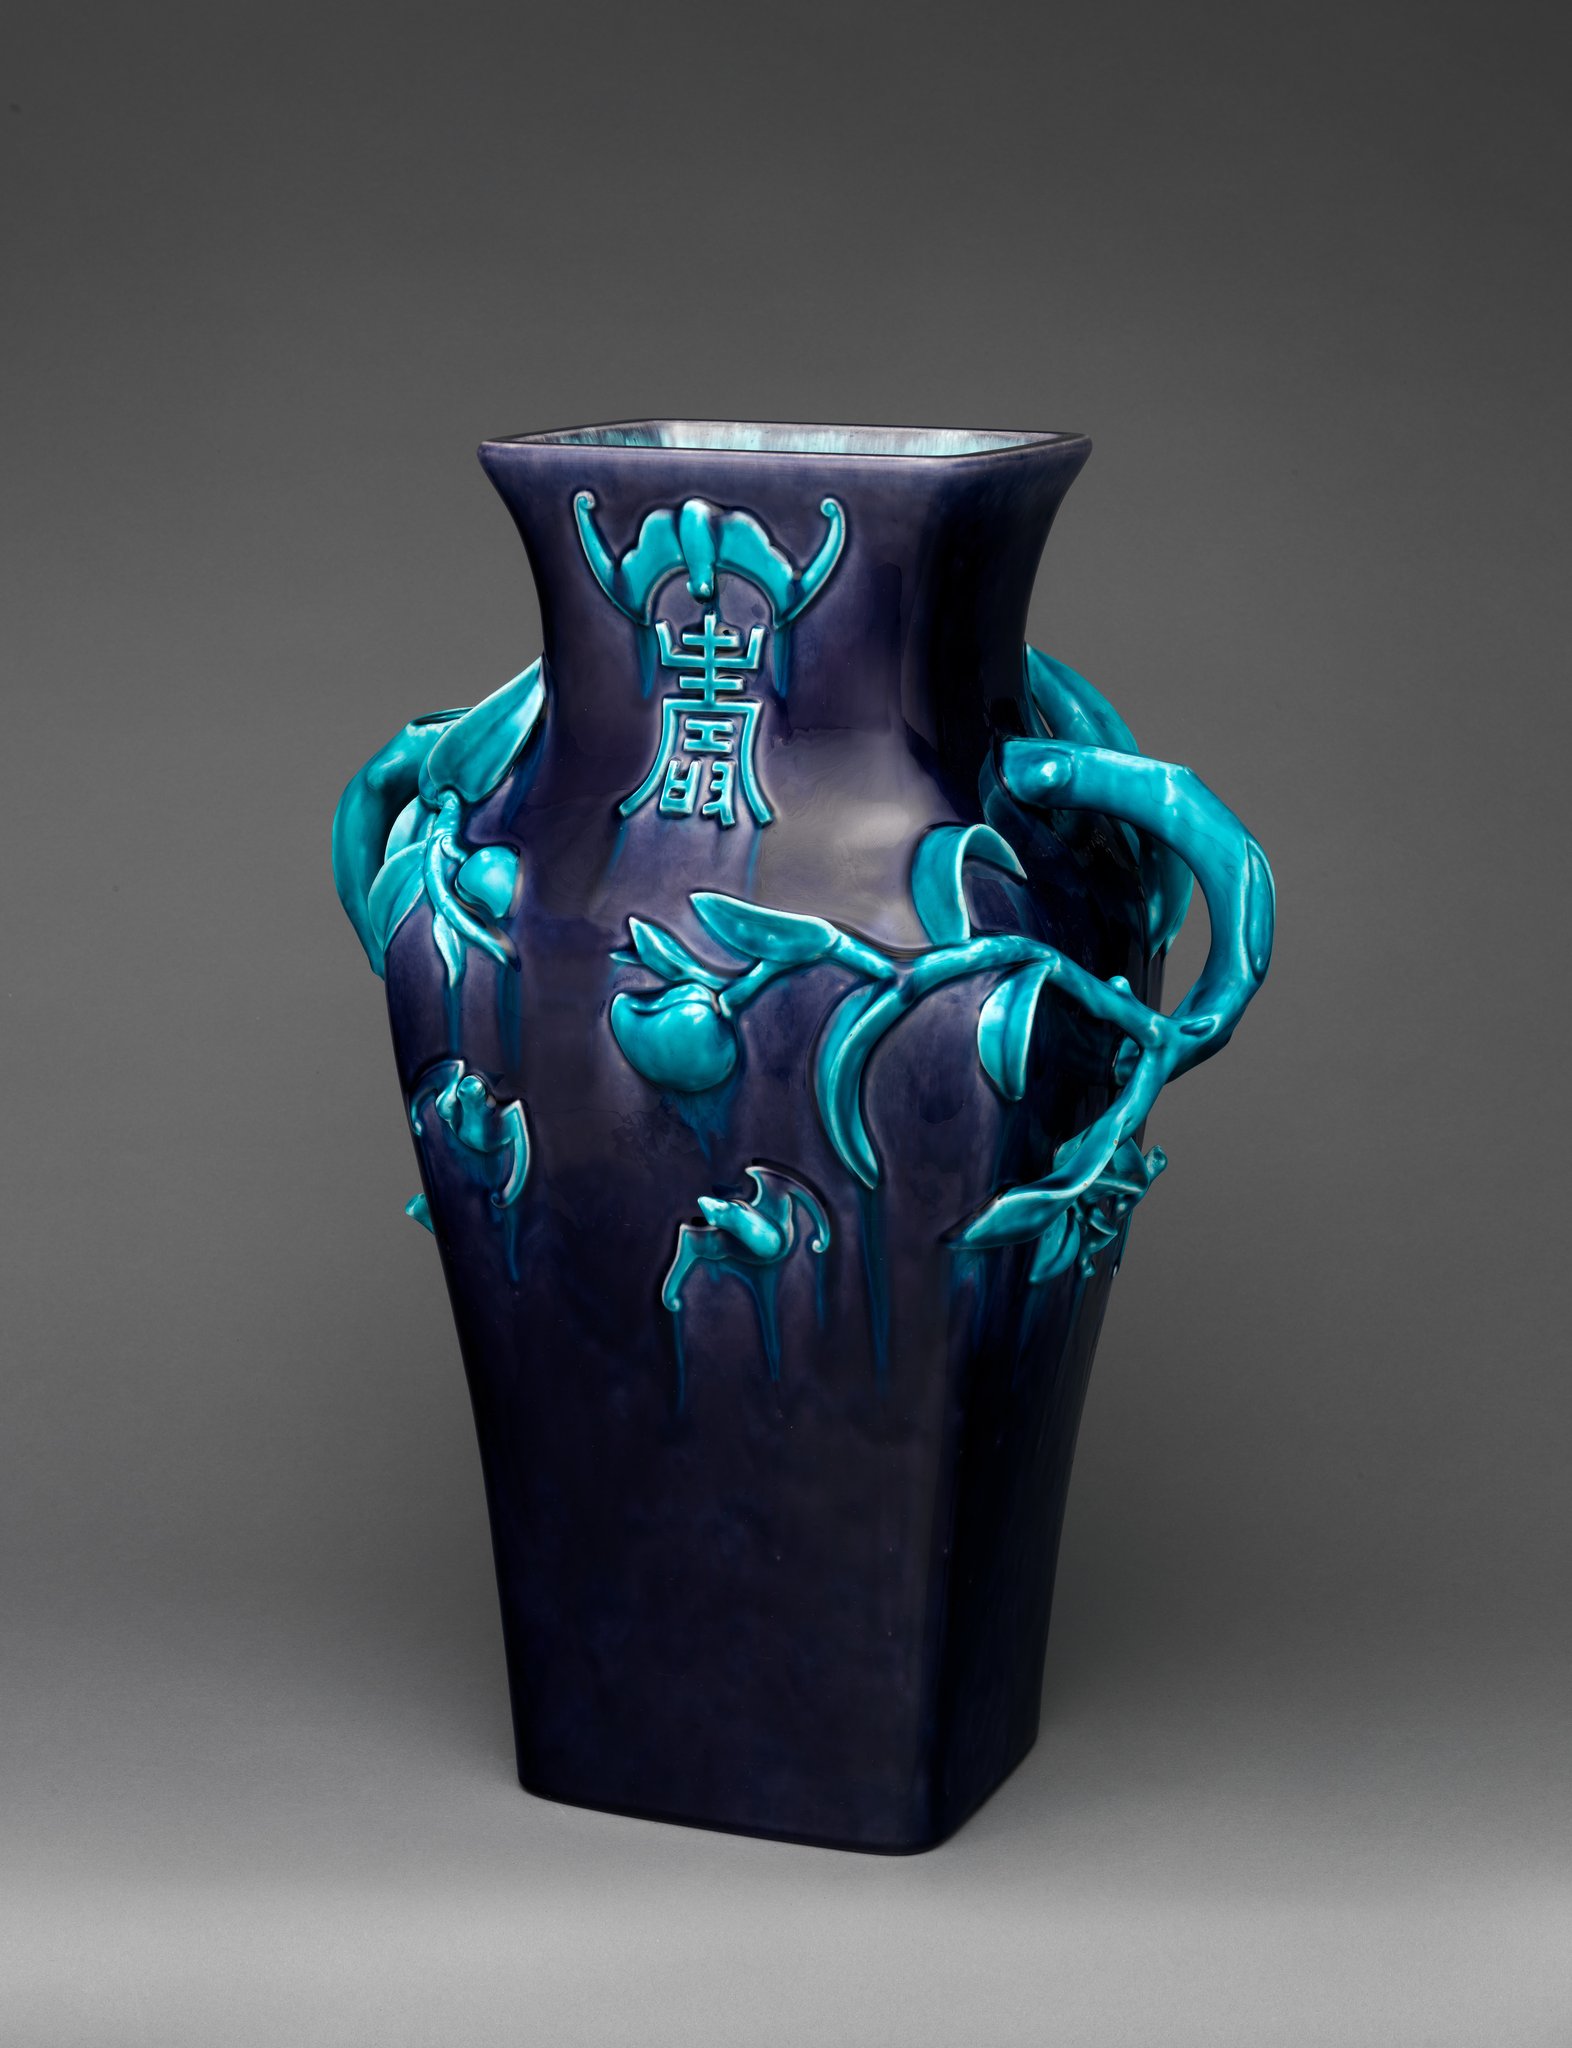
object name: vase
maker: joseph-théodore deck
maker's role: maker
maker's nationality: french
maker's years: 1823-1891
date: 1890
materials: earthenware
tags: bats,peaches